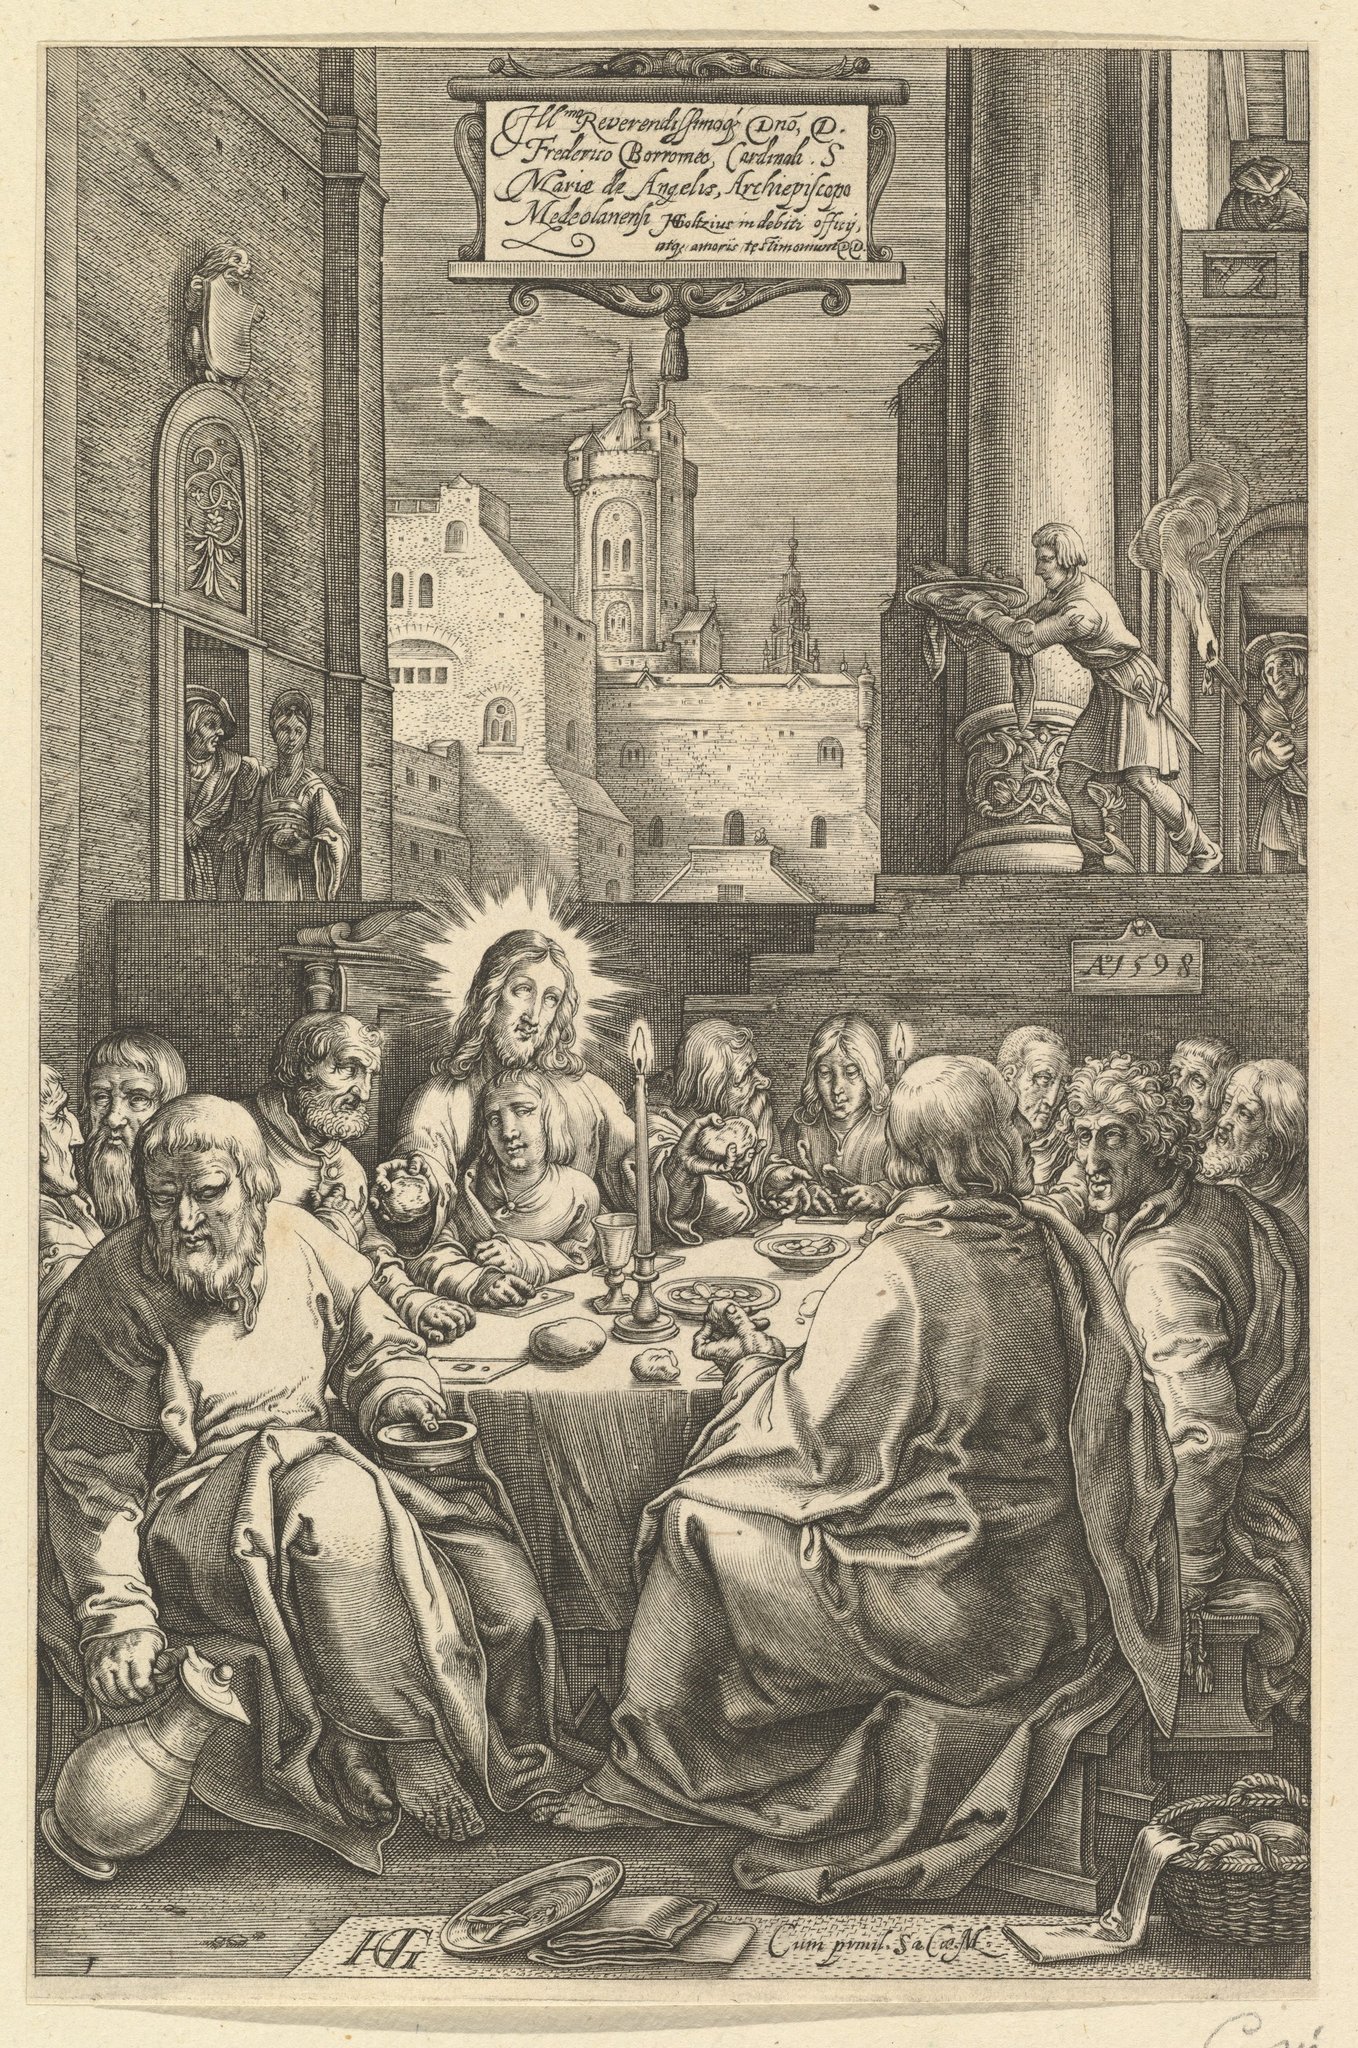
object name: print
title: The Last Supper, from "The Passion of Christ"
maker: Anonymous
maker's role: artist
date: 1598-1617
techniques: engraving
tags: apostles,christ,last supper